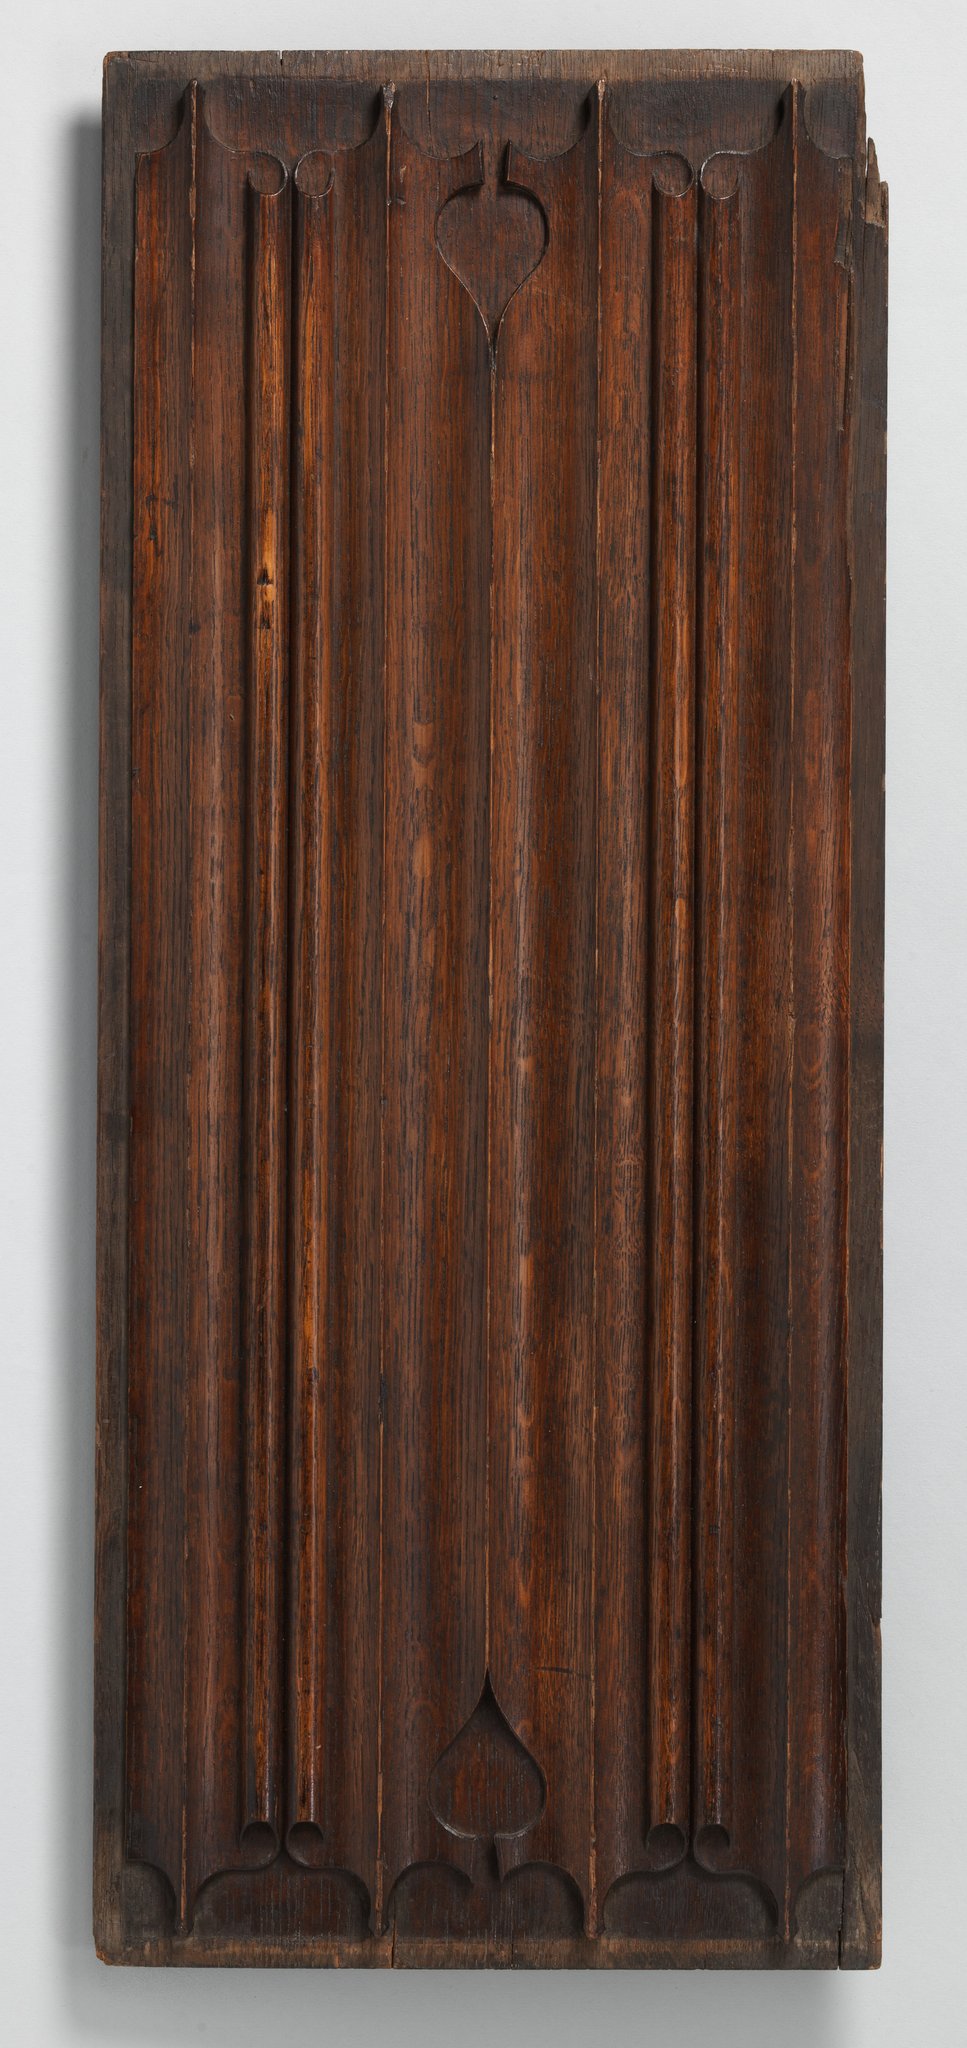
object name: panel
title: Decorative paneling from the Palace of Westminster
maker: augustus welby northmore pugin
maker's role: designer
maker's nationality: british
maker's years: 1812-1852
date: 1845-1859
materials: wood